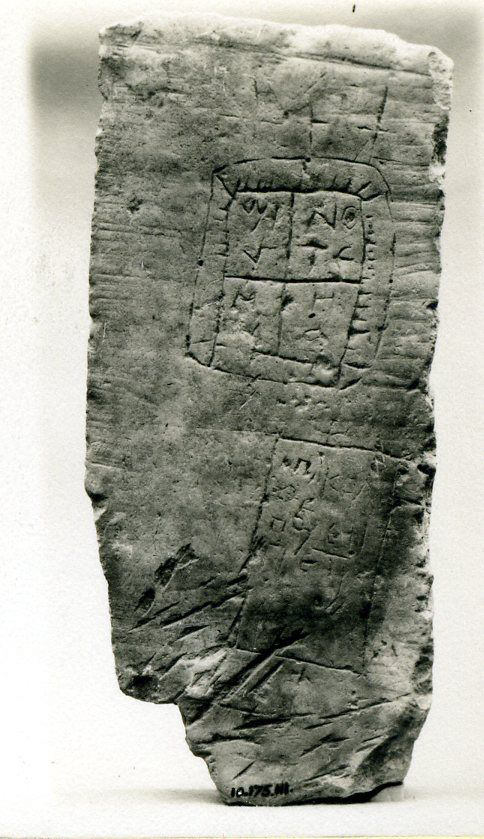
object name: stele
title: Stele with Inscribed Diagrams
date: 501-700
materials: limestone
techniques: incising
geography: egypt